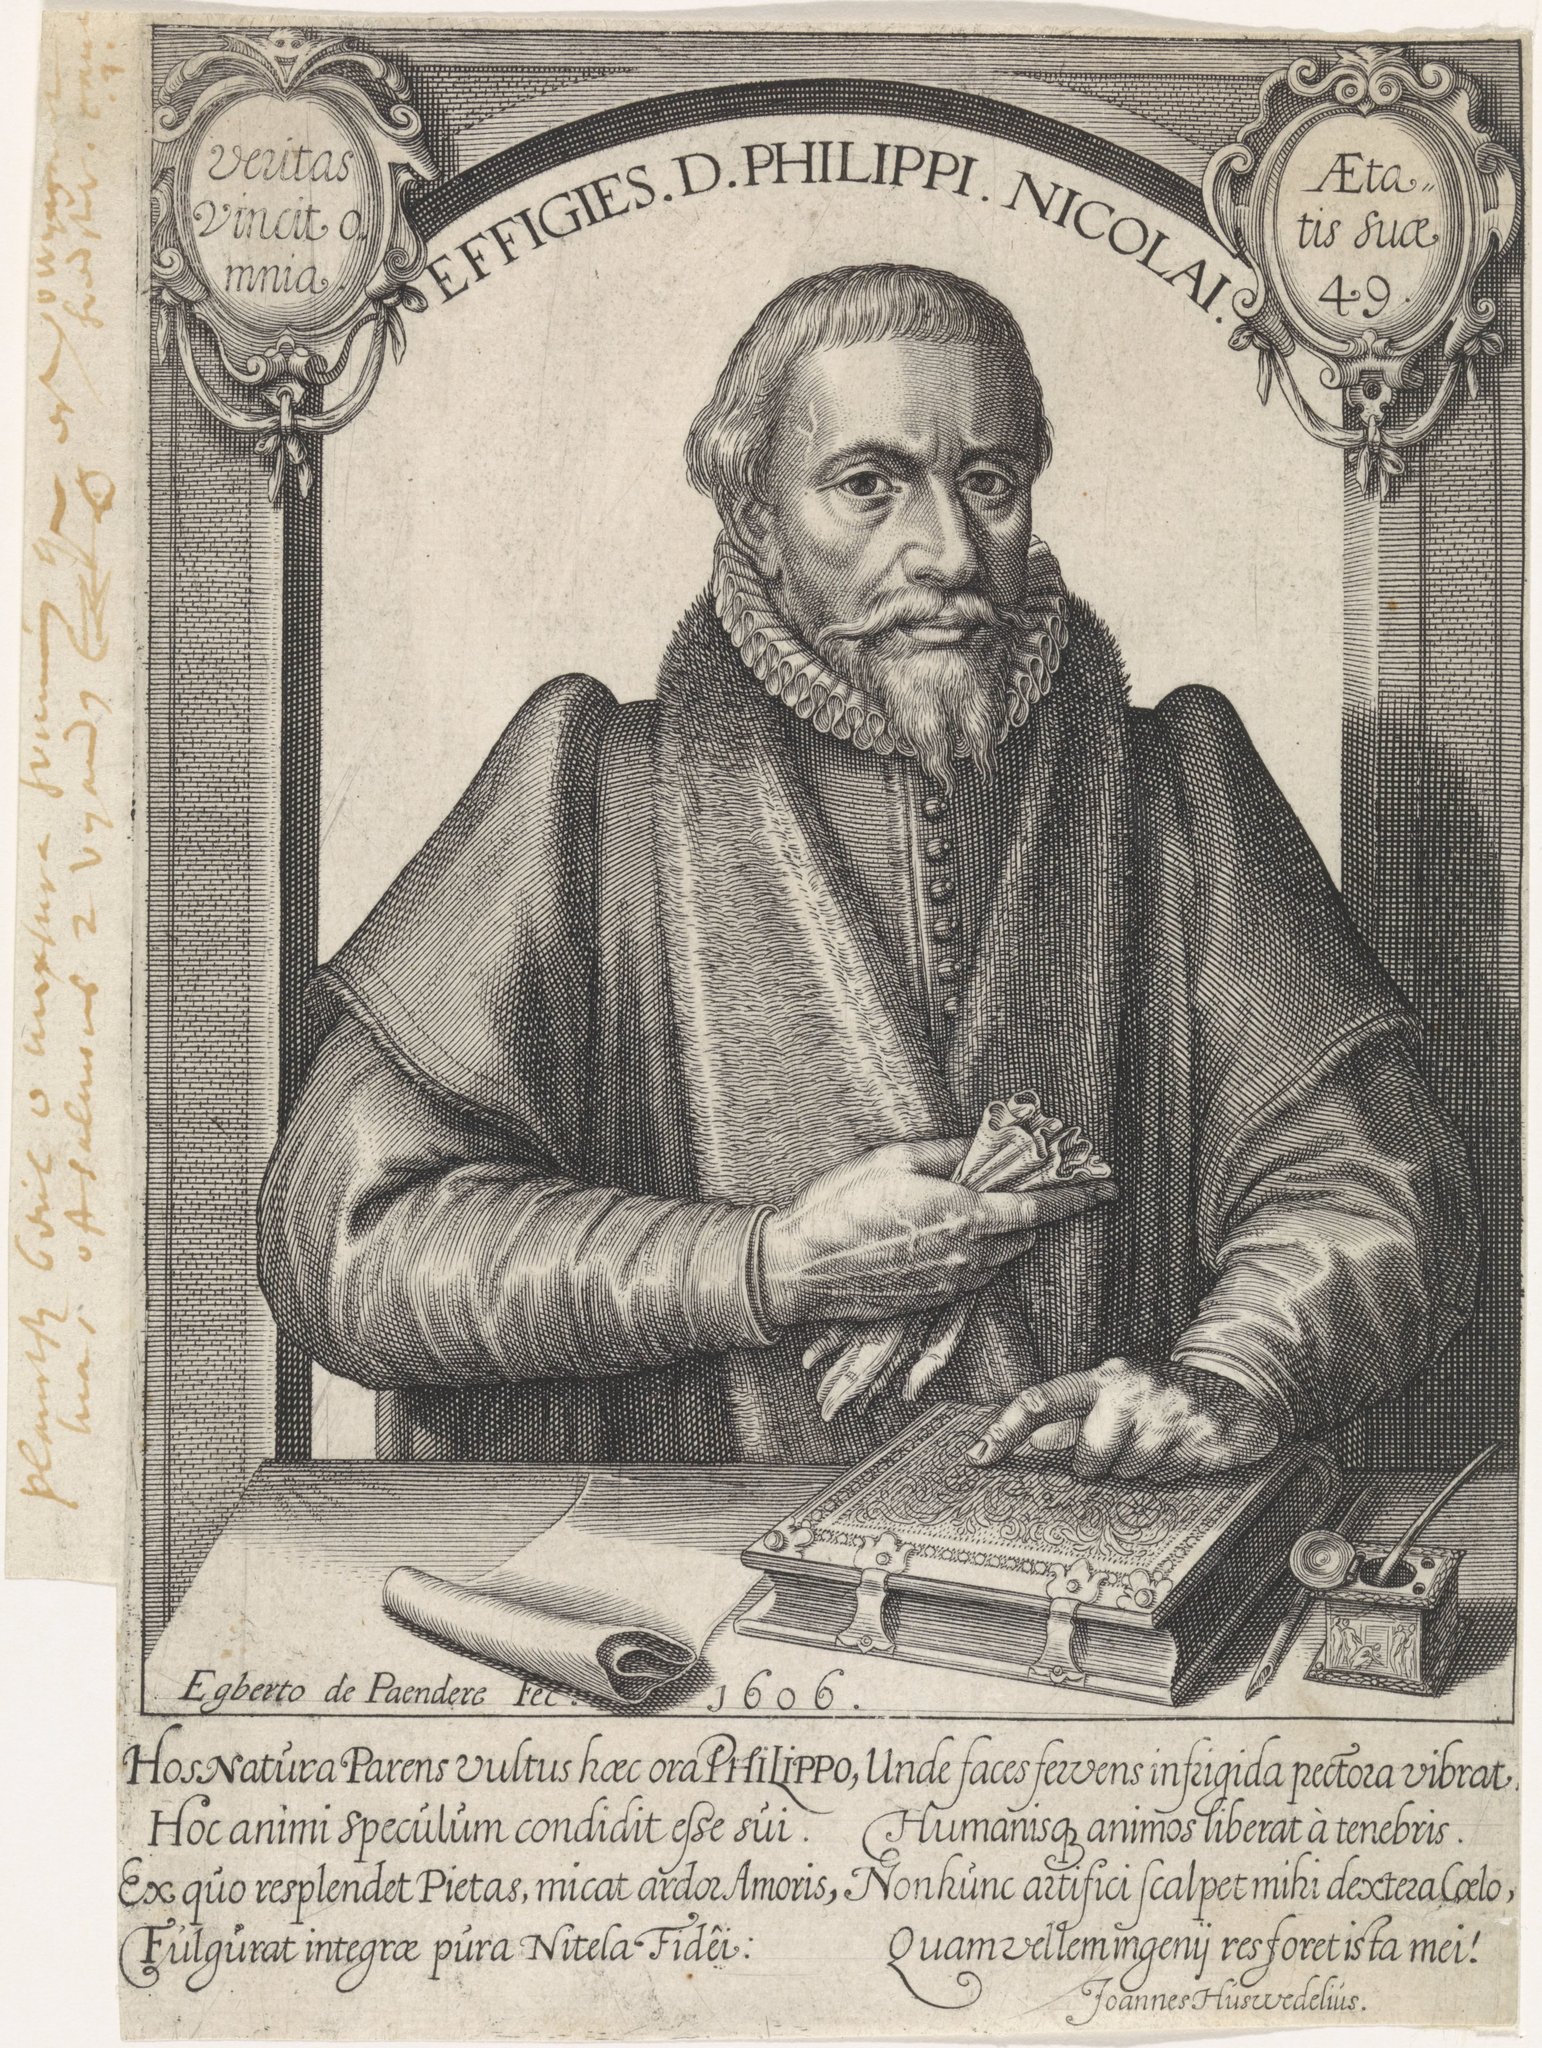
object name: print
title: Portret van Nicolaas Grudius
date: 1606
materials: paper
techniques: engraving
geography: antwerp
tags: venice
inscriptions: collector's mark: Lugt 2228, inscription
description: Portret van Nicolaas Grudius, op 49-jarige leeftijd. Hij draagt een plooikraag en een mantel. In zijn rechterhand houdt hij een handschoen en met zijn linkerhand wijst hij op een boek. De geportretteerde staat voor een boogvormige lijst met twee cartouches met tekst in het Latijn. In de marge een achtregelig onderschrift, in twee kolommen, in het Latijn.